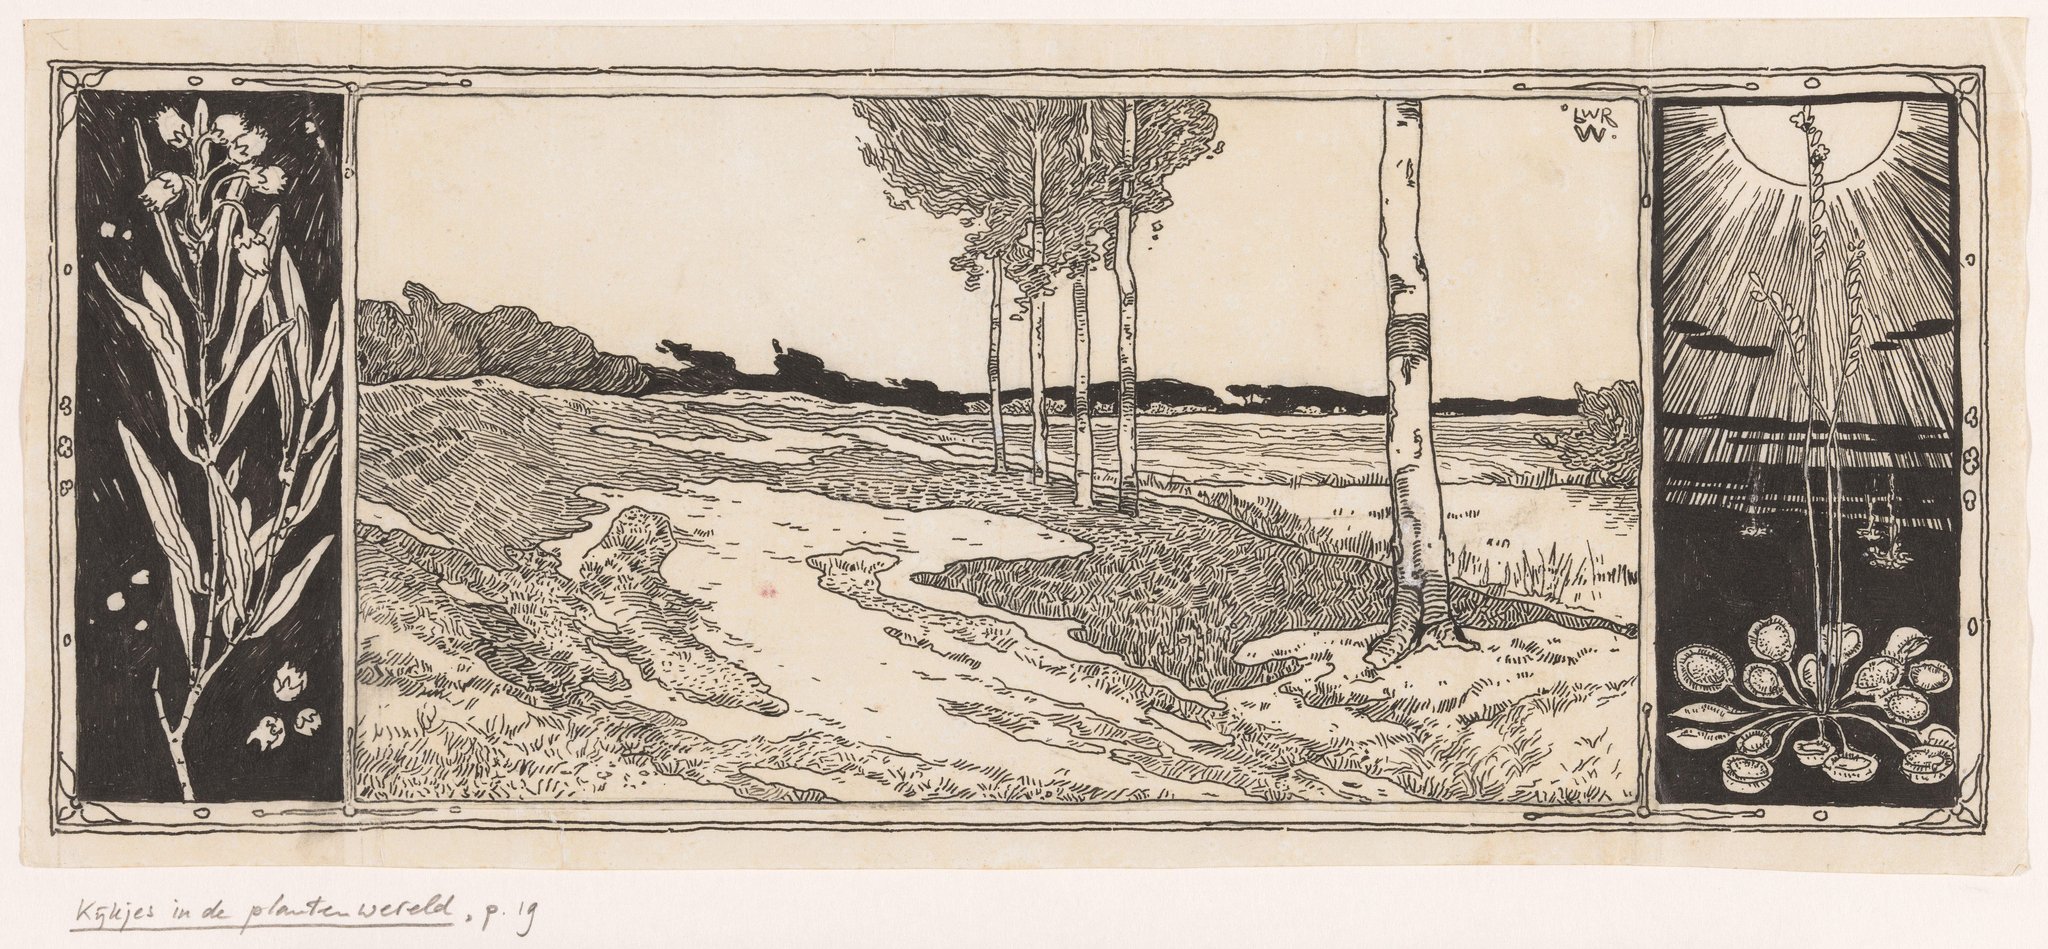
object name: boekillustratie ontwerp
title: Heidelandschap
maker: willem wenckebach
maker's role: designer, draughtsman, painter, print maker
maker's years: 1860-1937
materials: paint, ink, paper, pencil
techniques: brush, pen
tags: plants (in general), landscapes in the temperate zone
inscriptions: collector's mark: Lugt 2228a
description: Links van de voorstelling een decoratieve rand met een plant vermoedelijk een leeuwenbekje. Rechts een decoratieve rand met stralende zon en een vliegenvangertje.